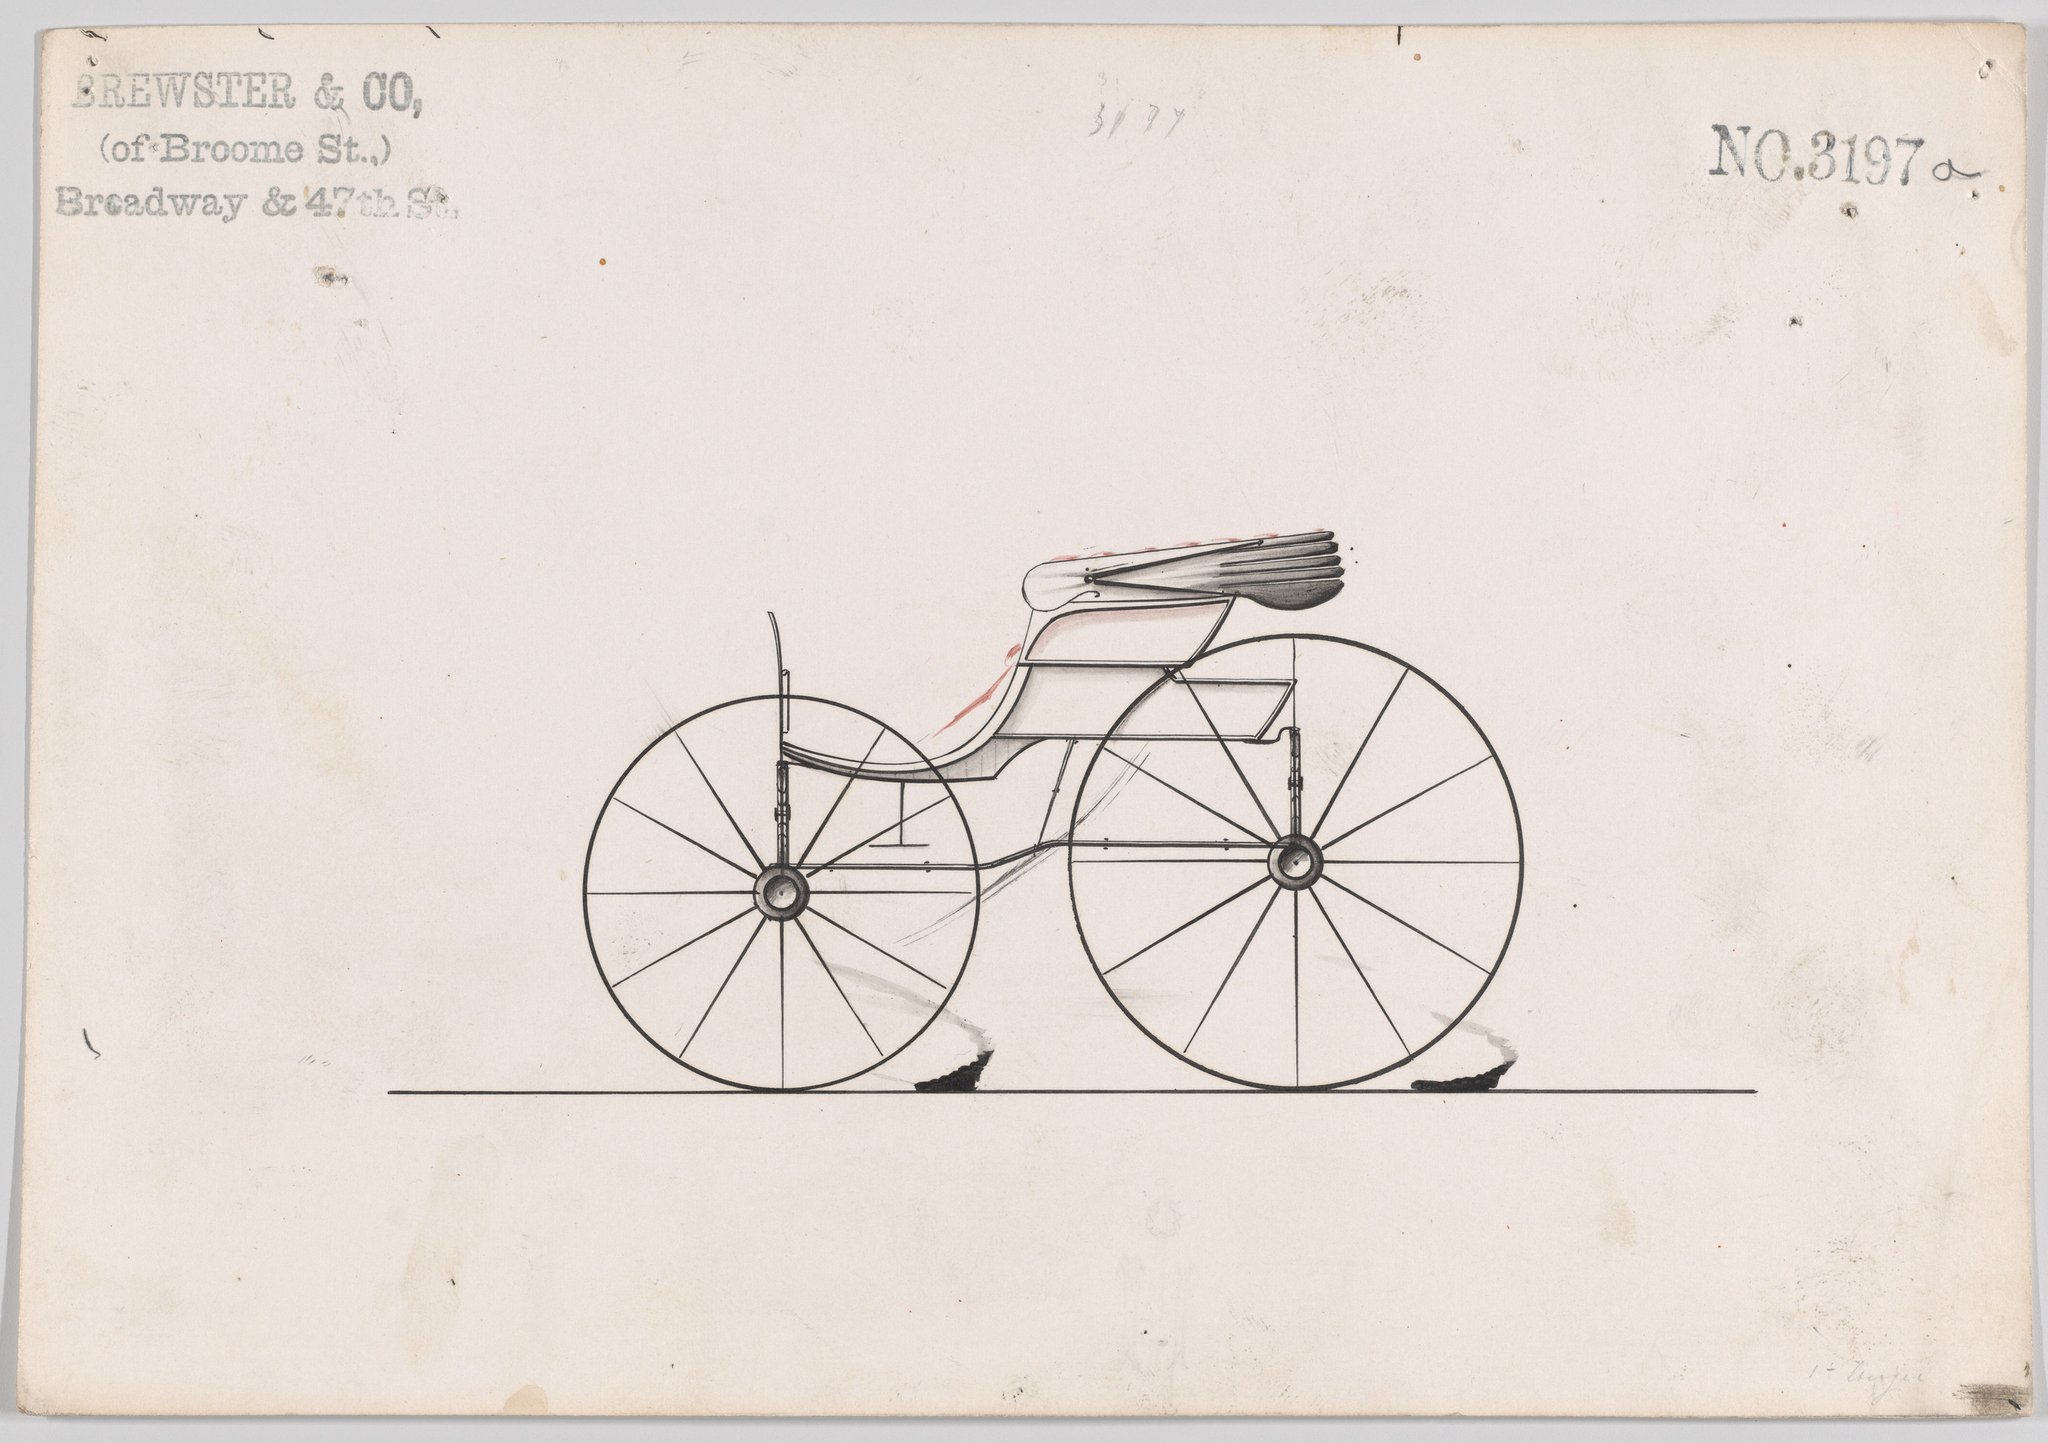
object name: drawing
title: Design for Pony Phaeton, no. 3197a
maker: brewster & co.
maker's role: manufacturer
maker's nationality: american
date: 1876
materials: gouache, ink, watercolor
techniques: pen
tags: carriages